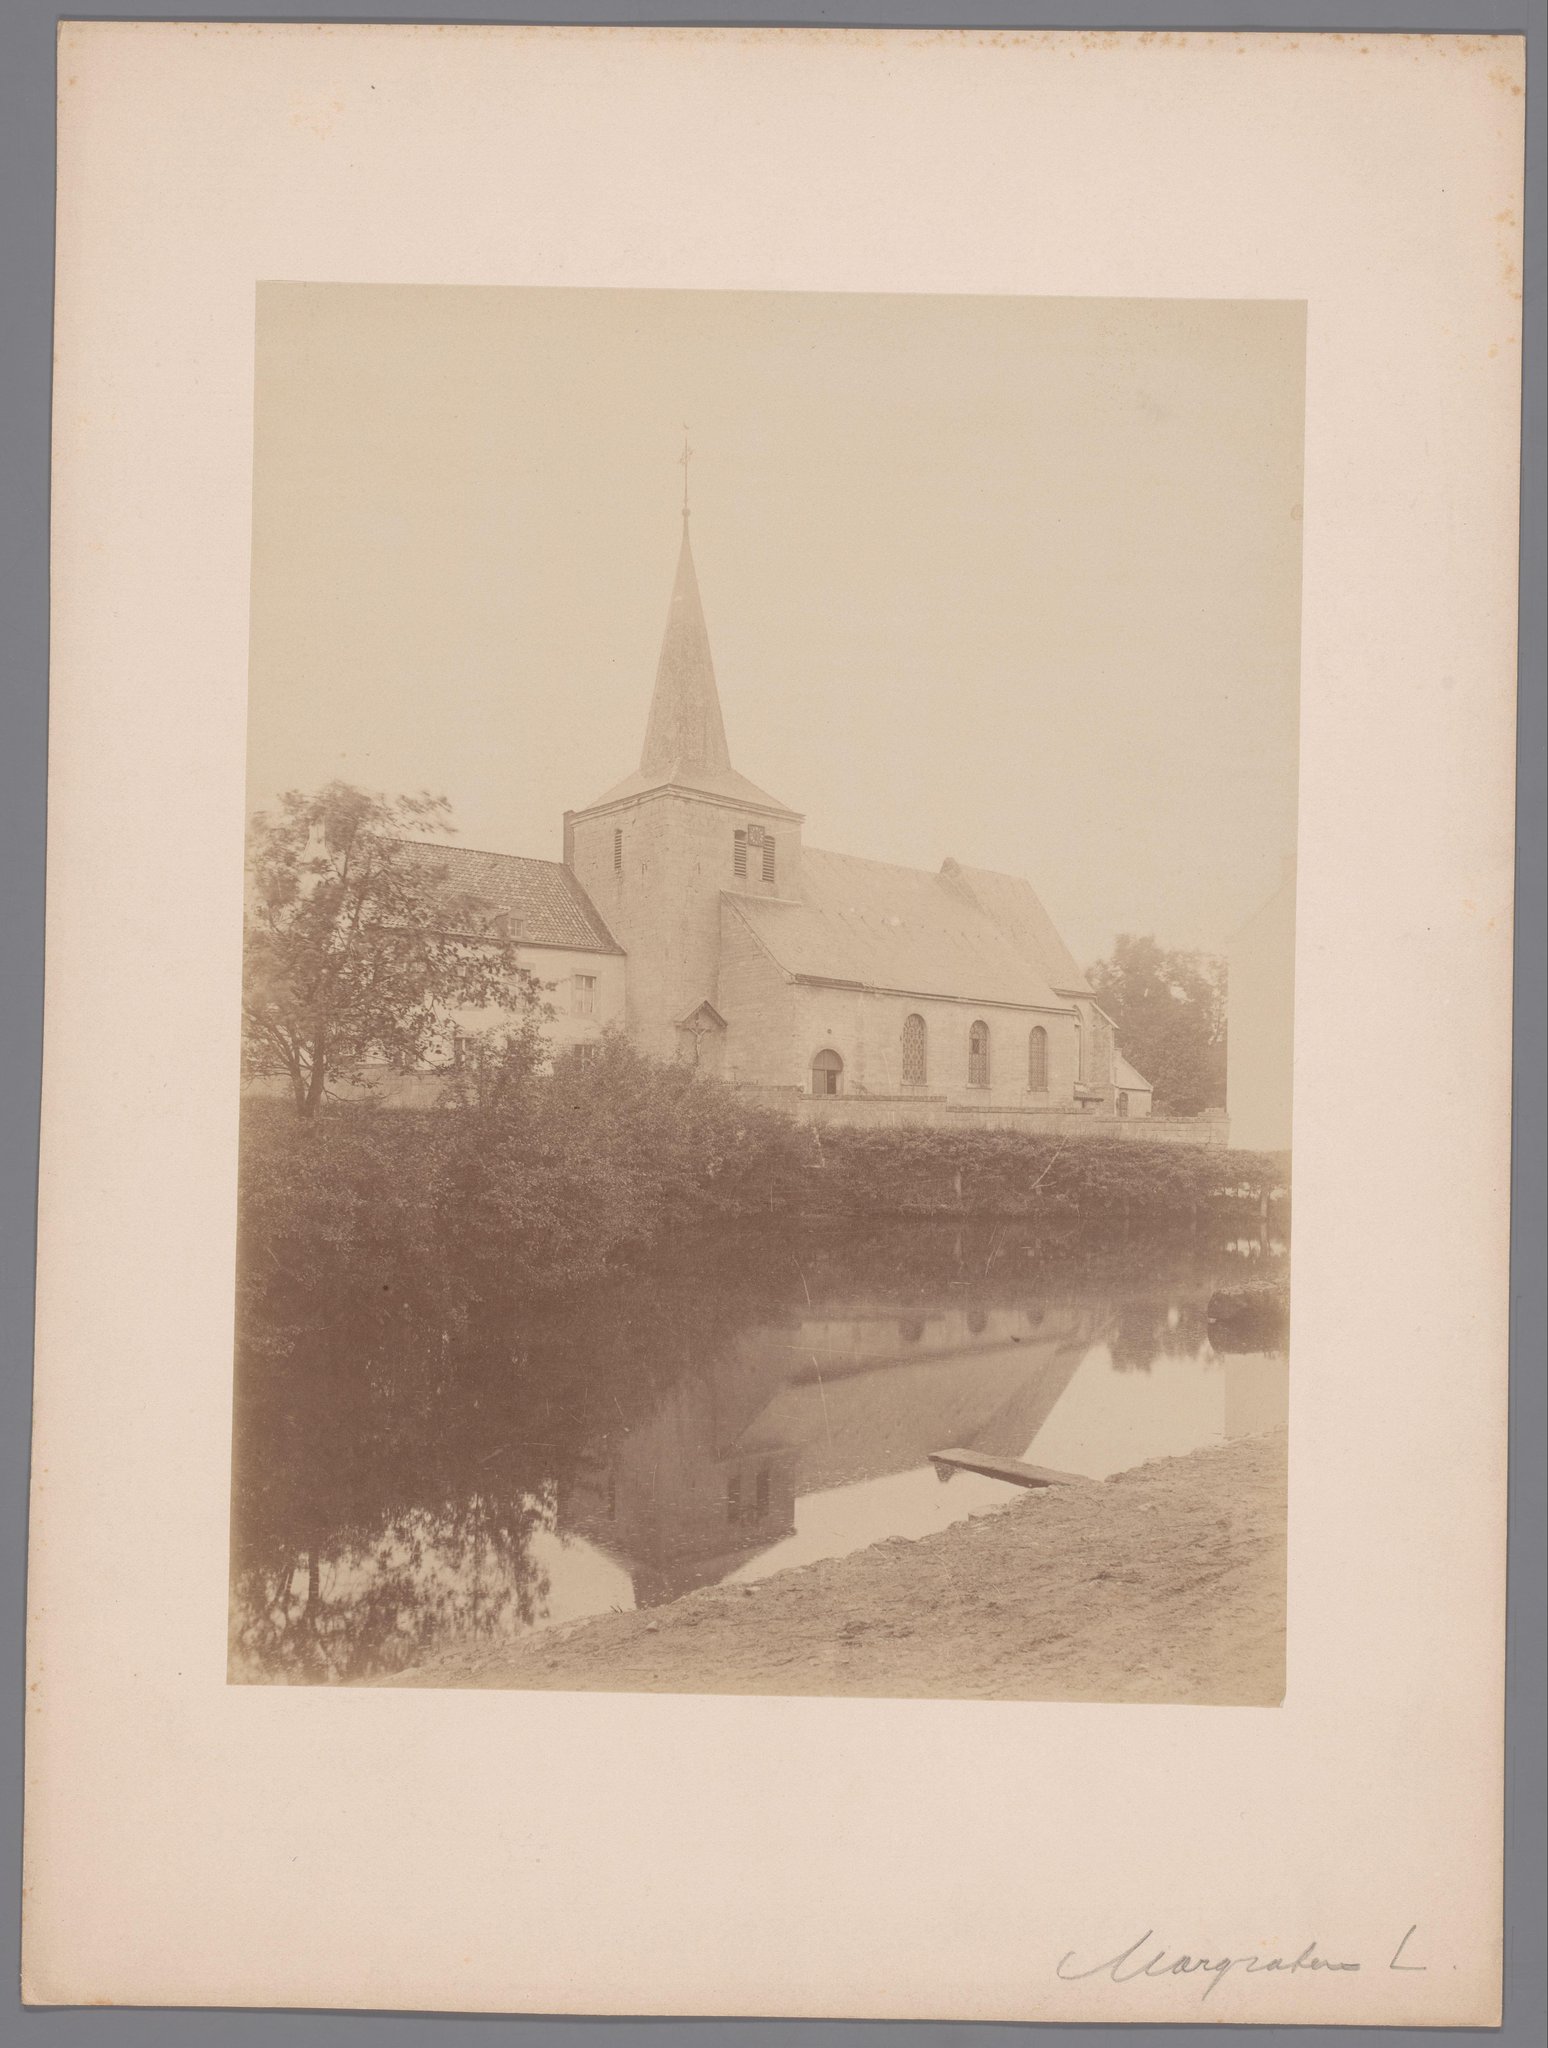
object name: photograph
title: Gezicht op de Sint-Margaritakerk te Margraten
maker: anoniem (monumentenzorg)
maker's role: fotograaf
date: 1895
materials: cardboard, photographic support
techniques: albumen print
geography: margraten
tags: church (exterior)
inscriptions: annotation: ‘R.K. Kerk te Margraten (Limburg)/ Aug 1895’, annotation: ‘Margraten L.’